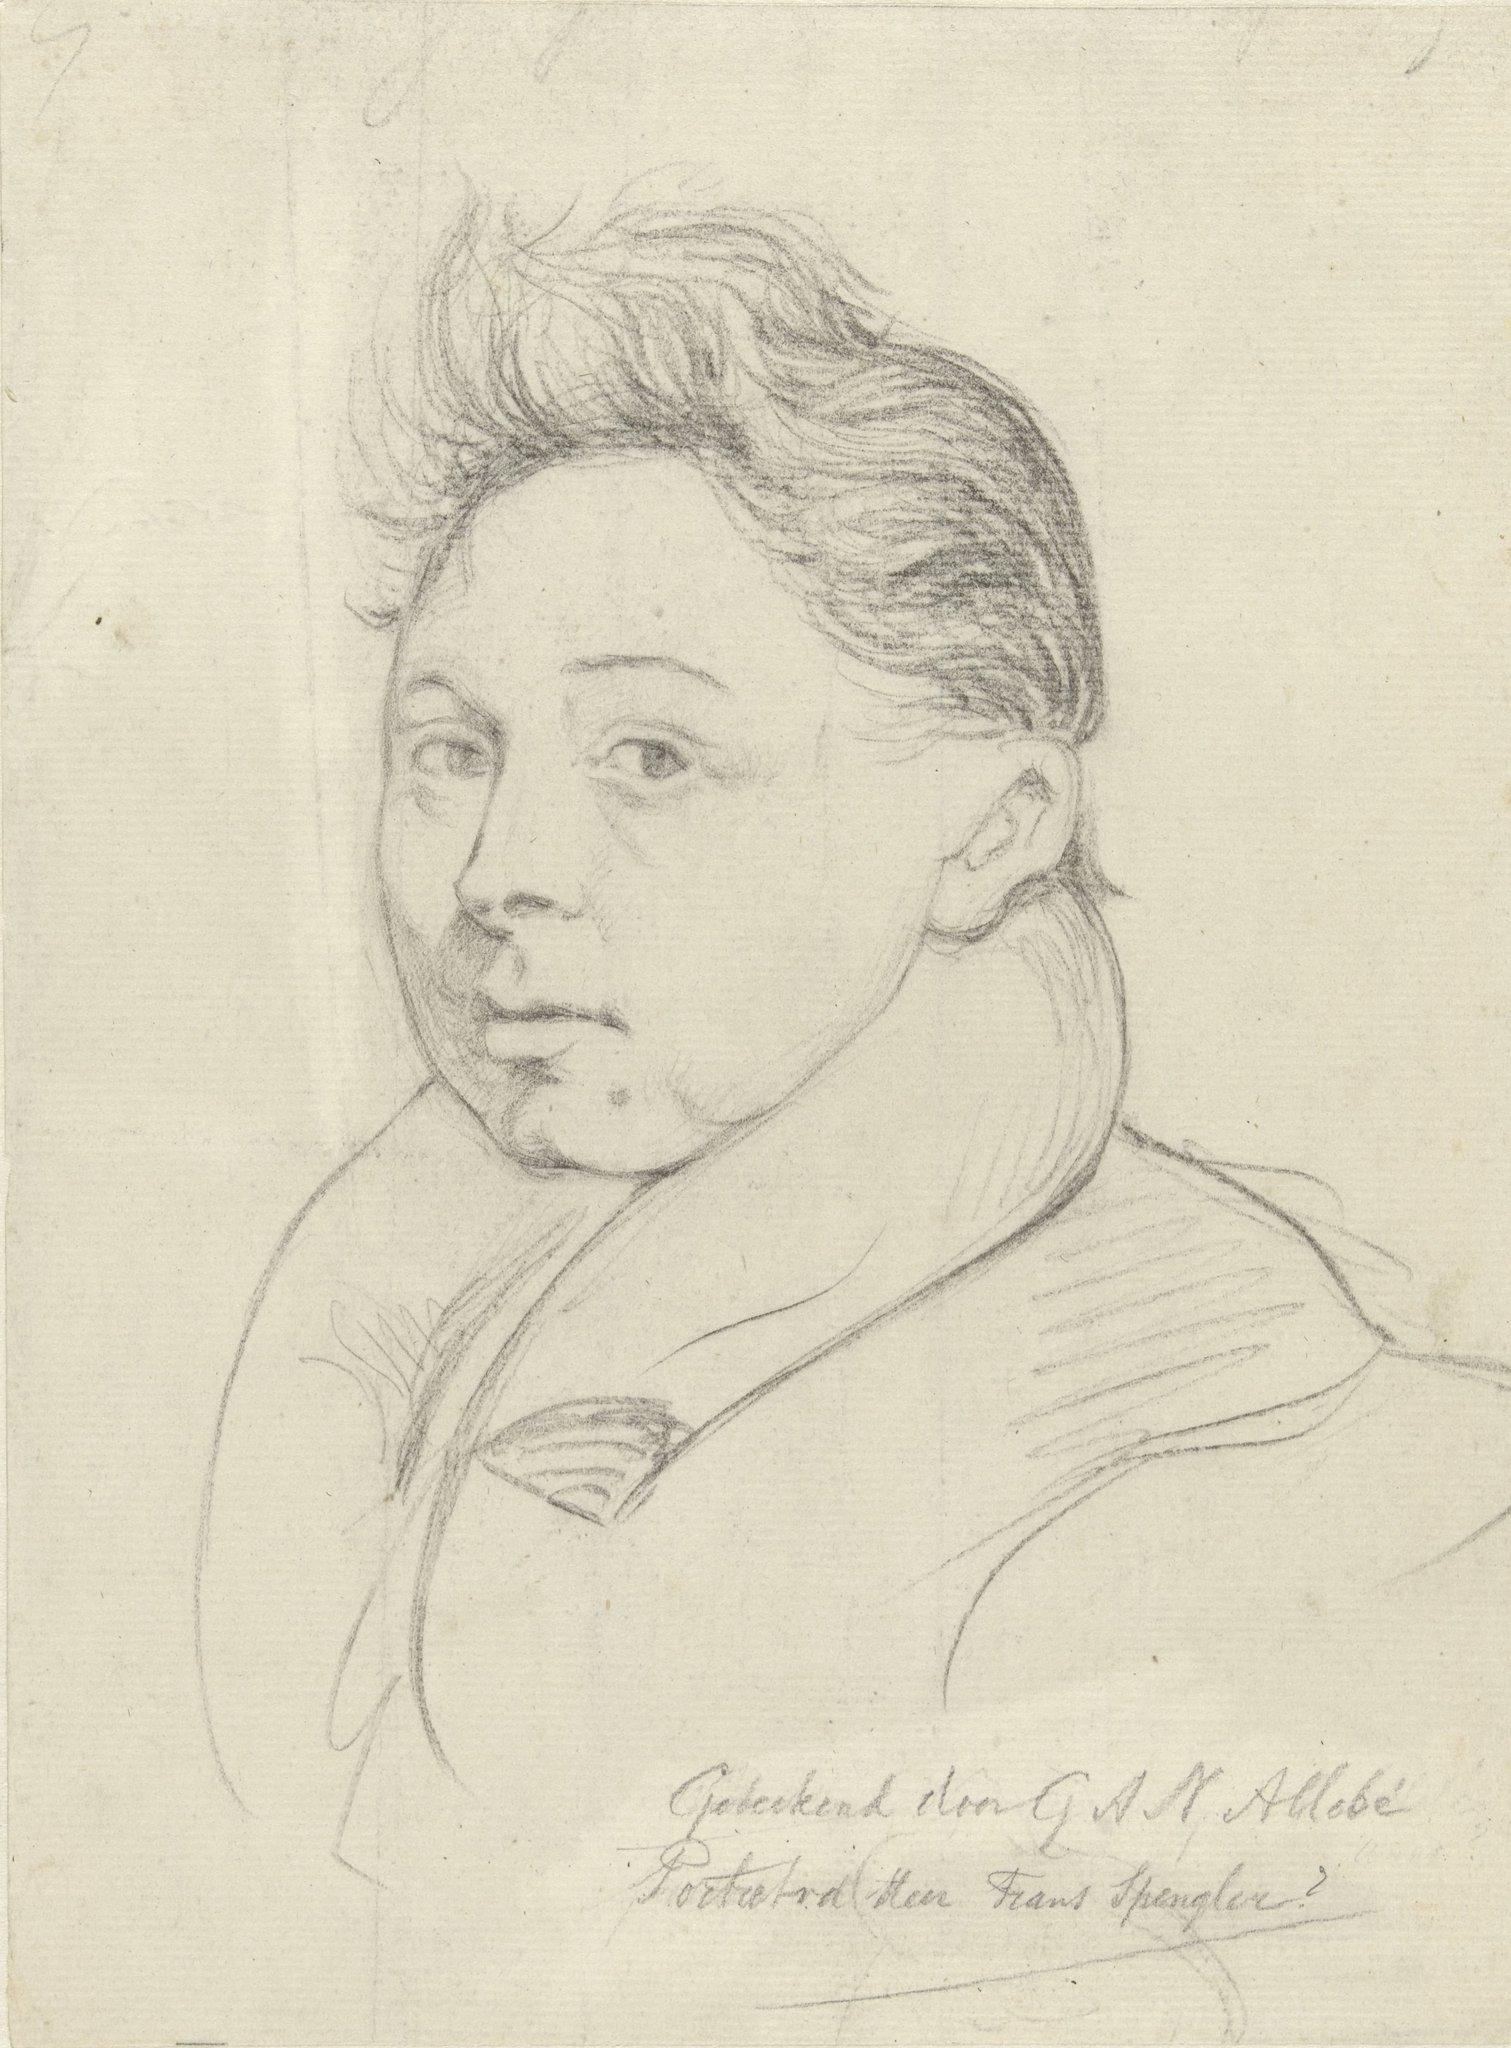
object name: drawing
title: Portret van de heer Frans Spengler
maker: august allebé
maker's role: draughtsman, print maker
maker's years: 1838-1927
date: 1848-1927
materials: chalk, paper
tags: historical persons